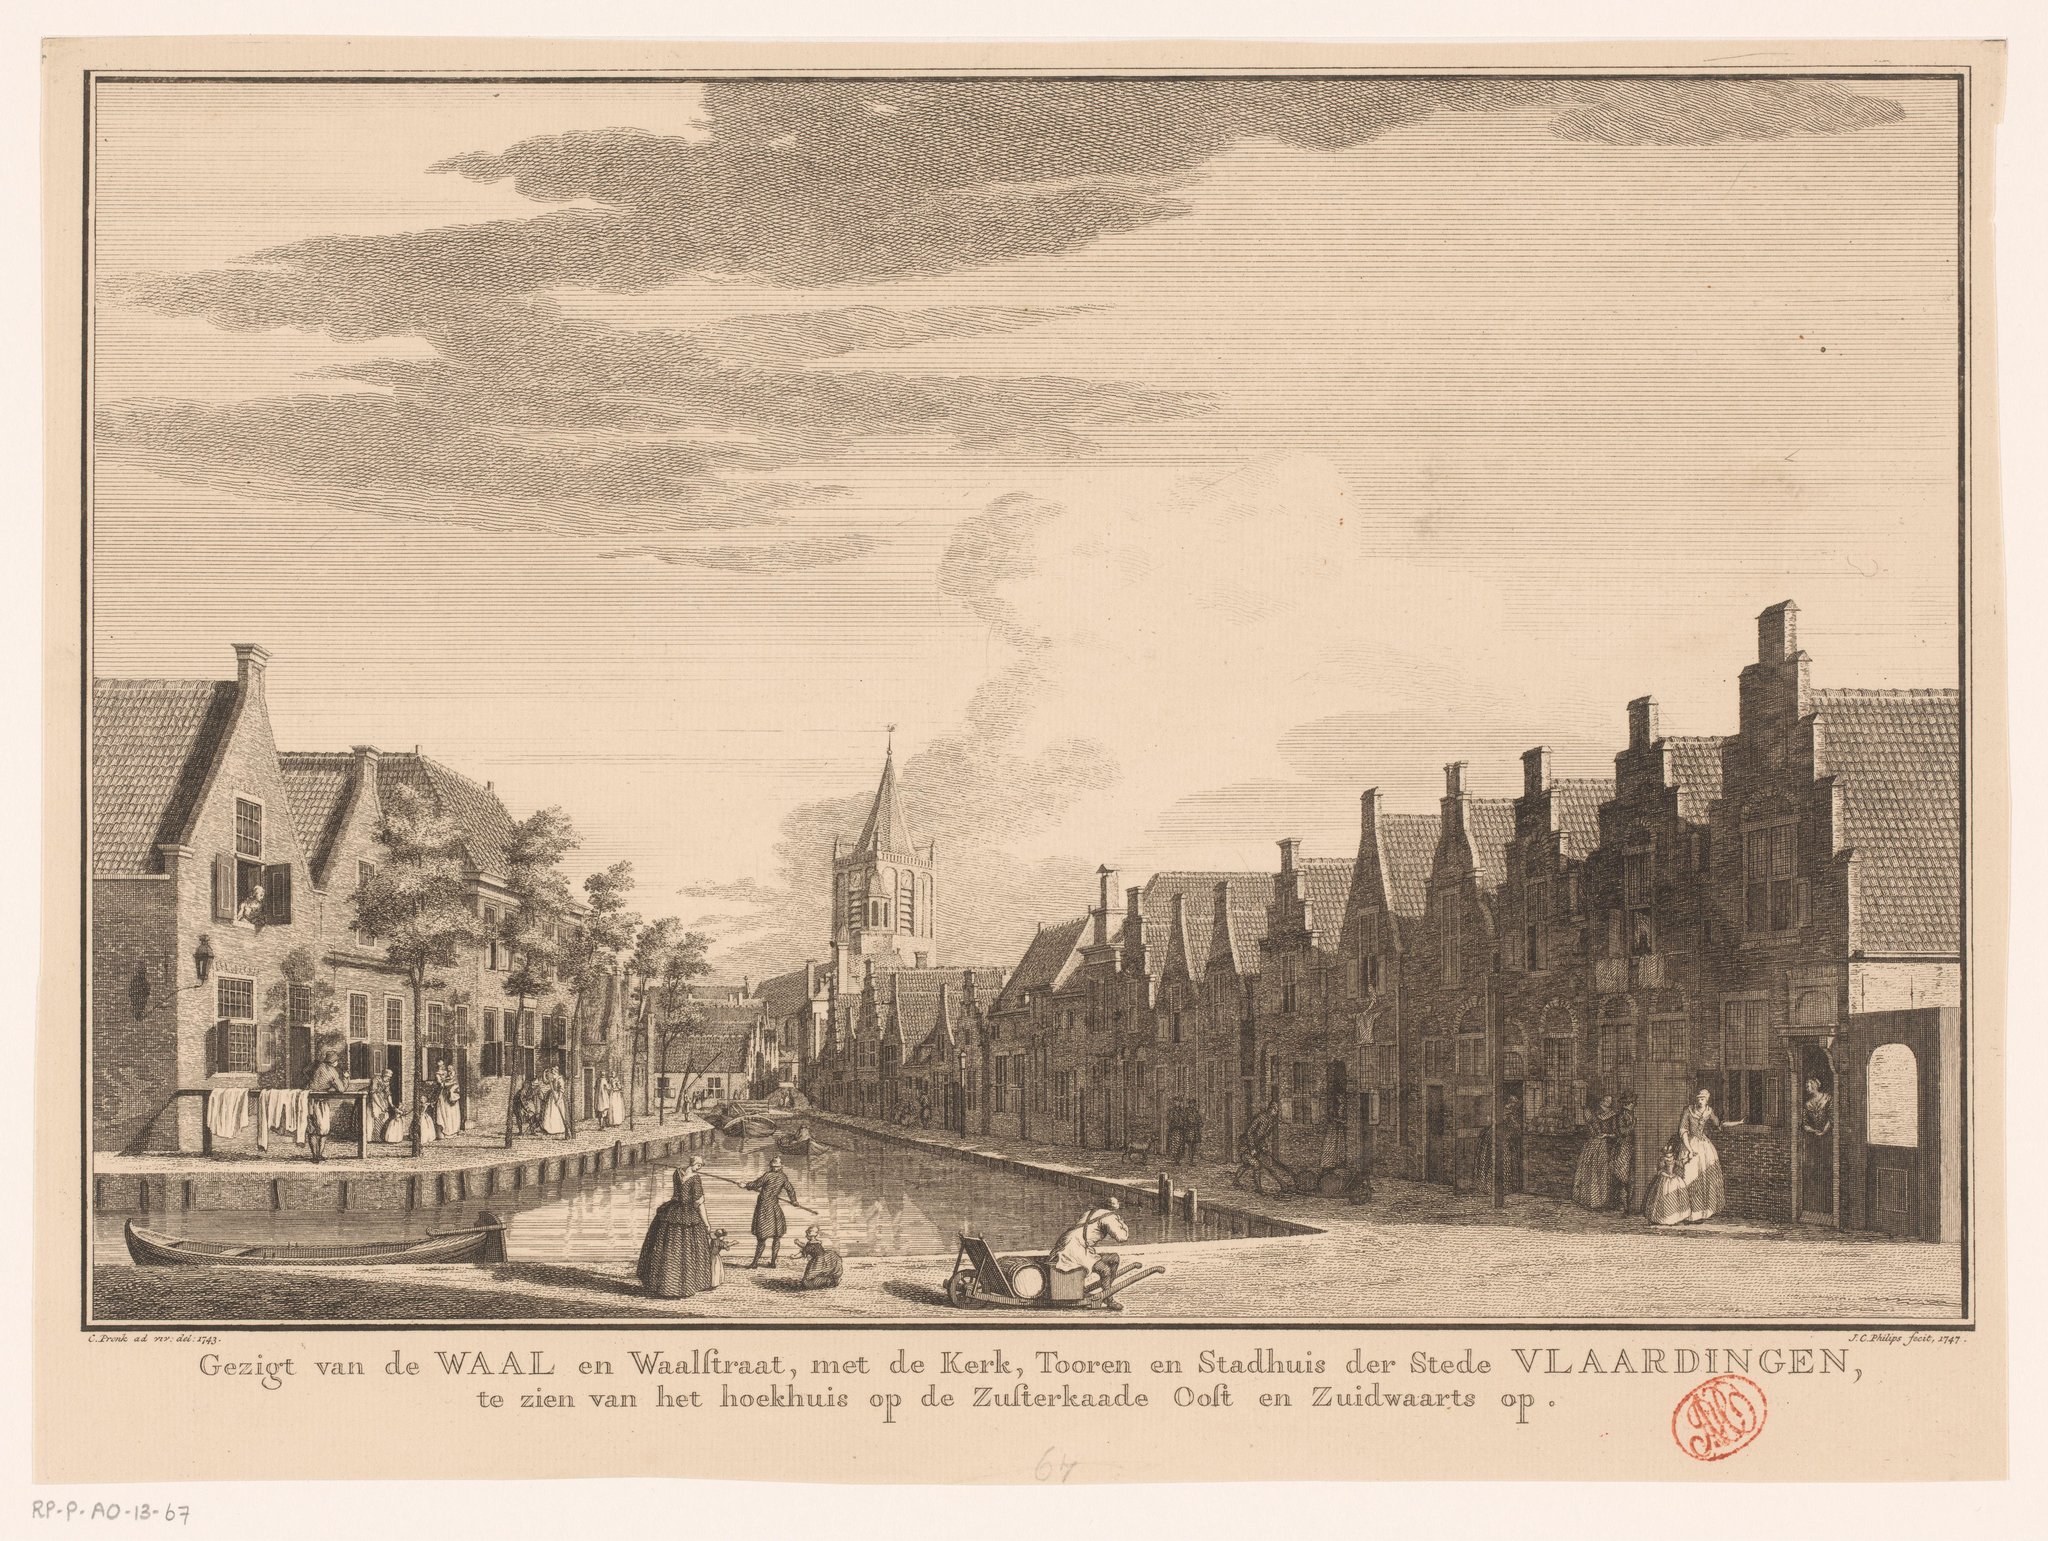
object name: print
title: Gezicht op de Waal en Waalstraat te Vlaardingen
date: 1747-1775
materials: paper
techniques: etching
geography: amsterdam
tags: townhall, canals, waters (in city) (+ city(-scape) with figures, staffage), street (+ city(-scape) with figures, staffage), parts of church exterior and annexes: tower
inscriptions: collector's mark: Lugt 195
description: Prent ook gebruikt in: Handvesten, octroyen, privilegien en regten, aan de stede Vlaardingen (…) en met der stede grondteekening en andere kopere plaaten verçiert (…). Den Haag: Johannes Gaillard, 1772. En in: Handvesten, octroyen, privilegien en regten, aan de stede Vlaardingen (…) en met der stede grondteekening en andere kopere plaaten verçiert (…). Utrecht: Johannes van Schoonhoven, 1775.